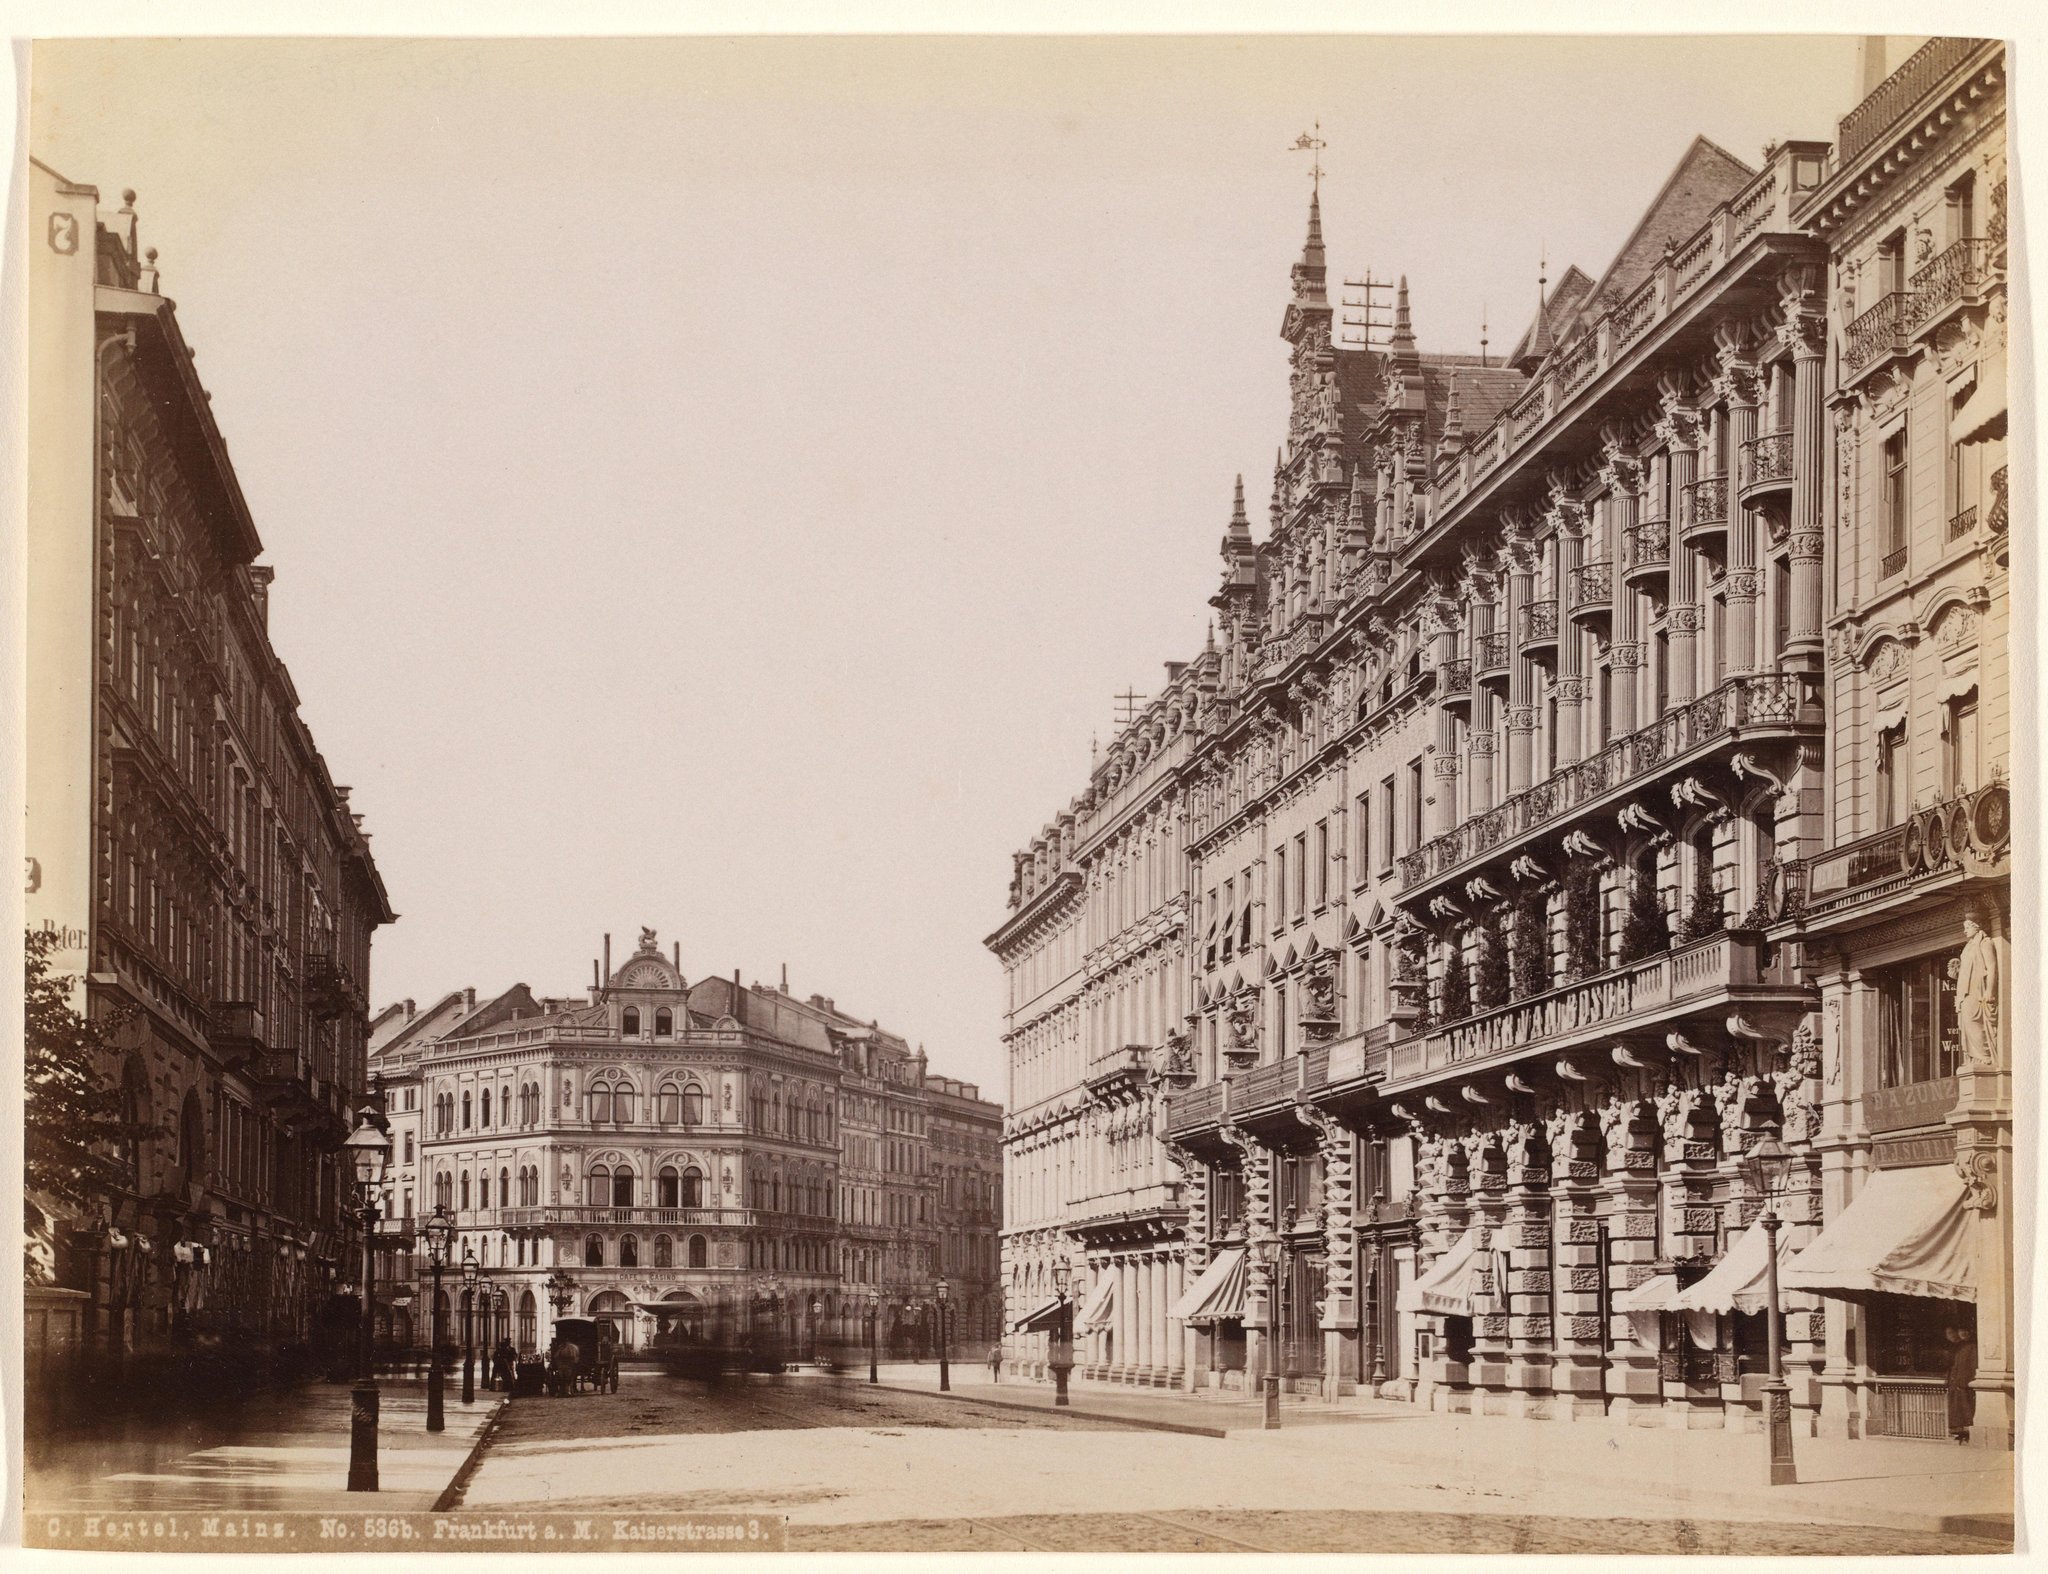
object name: photograph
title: Frankfurt a. M., Kaiserstrasse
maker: carl hertel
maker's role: publisher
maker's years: 1832-1906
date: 1880-1904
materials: paper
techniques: albumen print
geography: frankfurt am main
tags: street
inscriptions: stamp: ‘Photographie/ C. Hertel, Mainz/ grosse Bleiche 50’, inscription: ‘C. Hertel, Mainz. No 536b, Frankfurt a. M. Kaiserstrasse 3.’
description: Rechts is de fotostudio Atelier van Bosch aan Kaiserstraße 34 te zien.